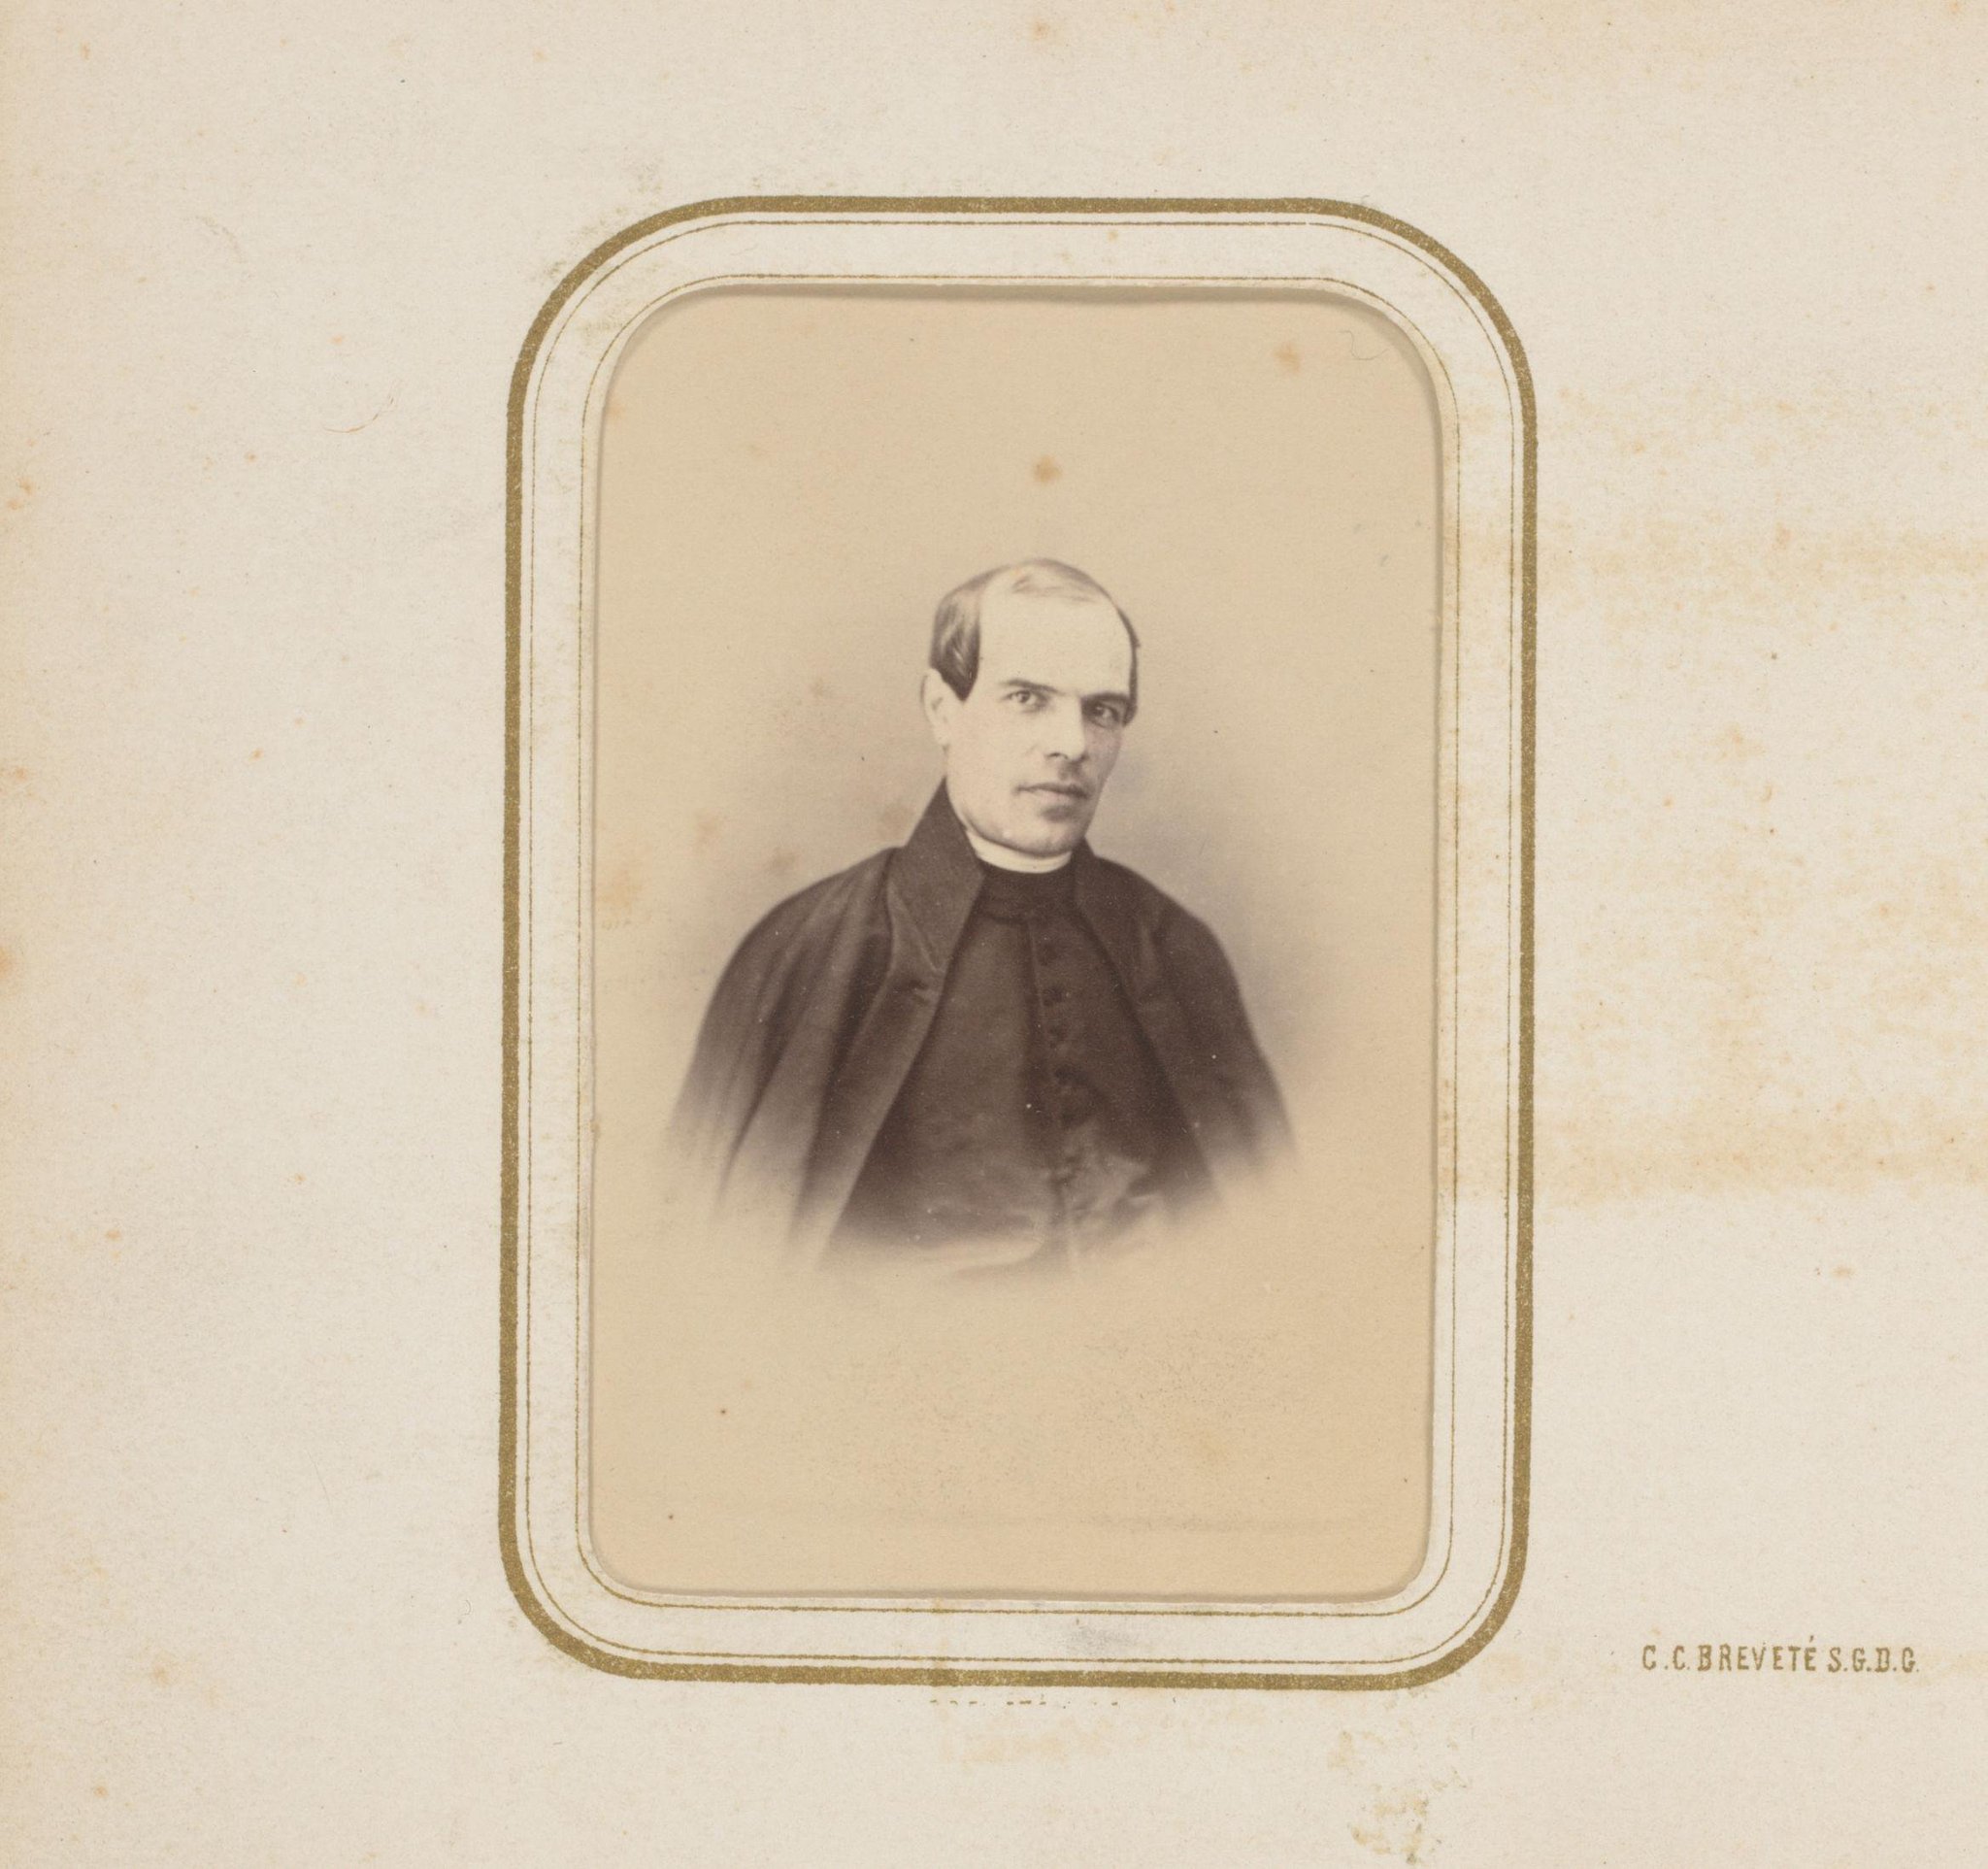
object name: photograph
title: Portret van een man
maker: antonio sanchez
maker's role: fotograaf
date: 1860-1900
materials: cardboard, photographic support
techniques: albumen print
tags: adult man, historical persons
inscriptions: inscription: ‘Litografia/ y fotografia/ de. A. Sanchez/ Premiado con Medalla de oro/ Carrera de Genil No 41/ Granada’